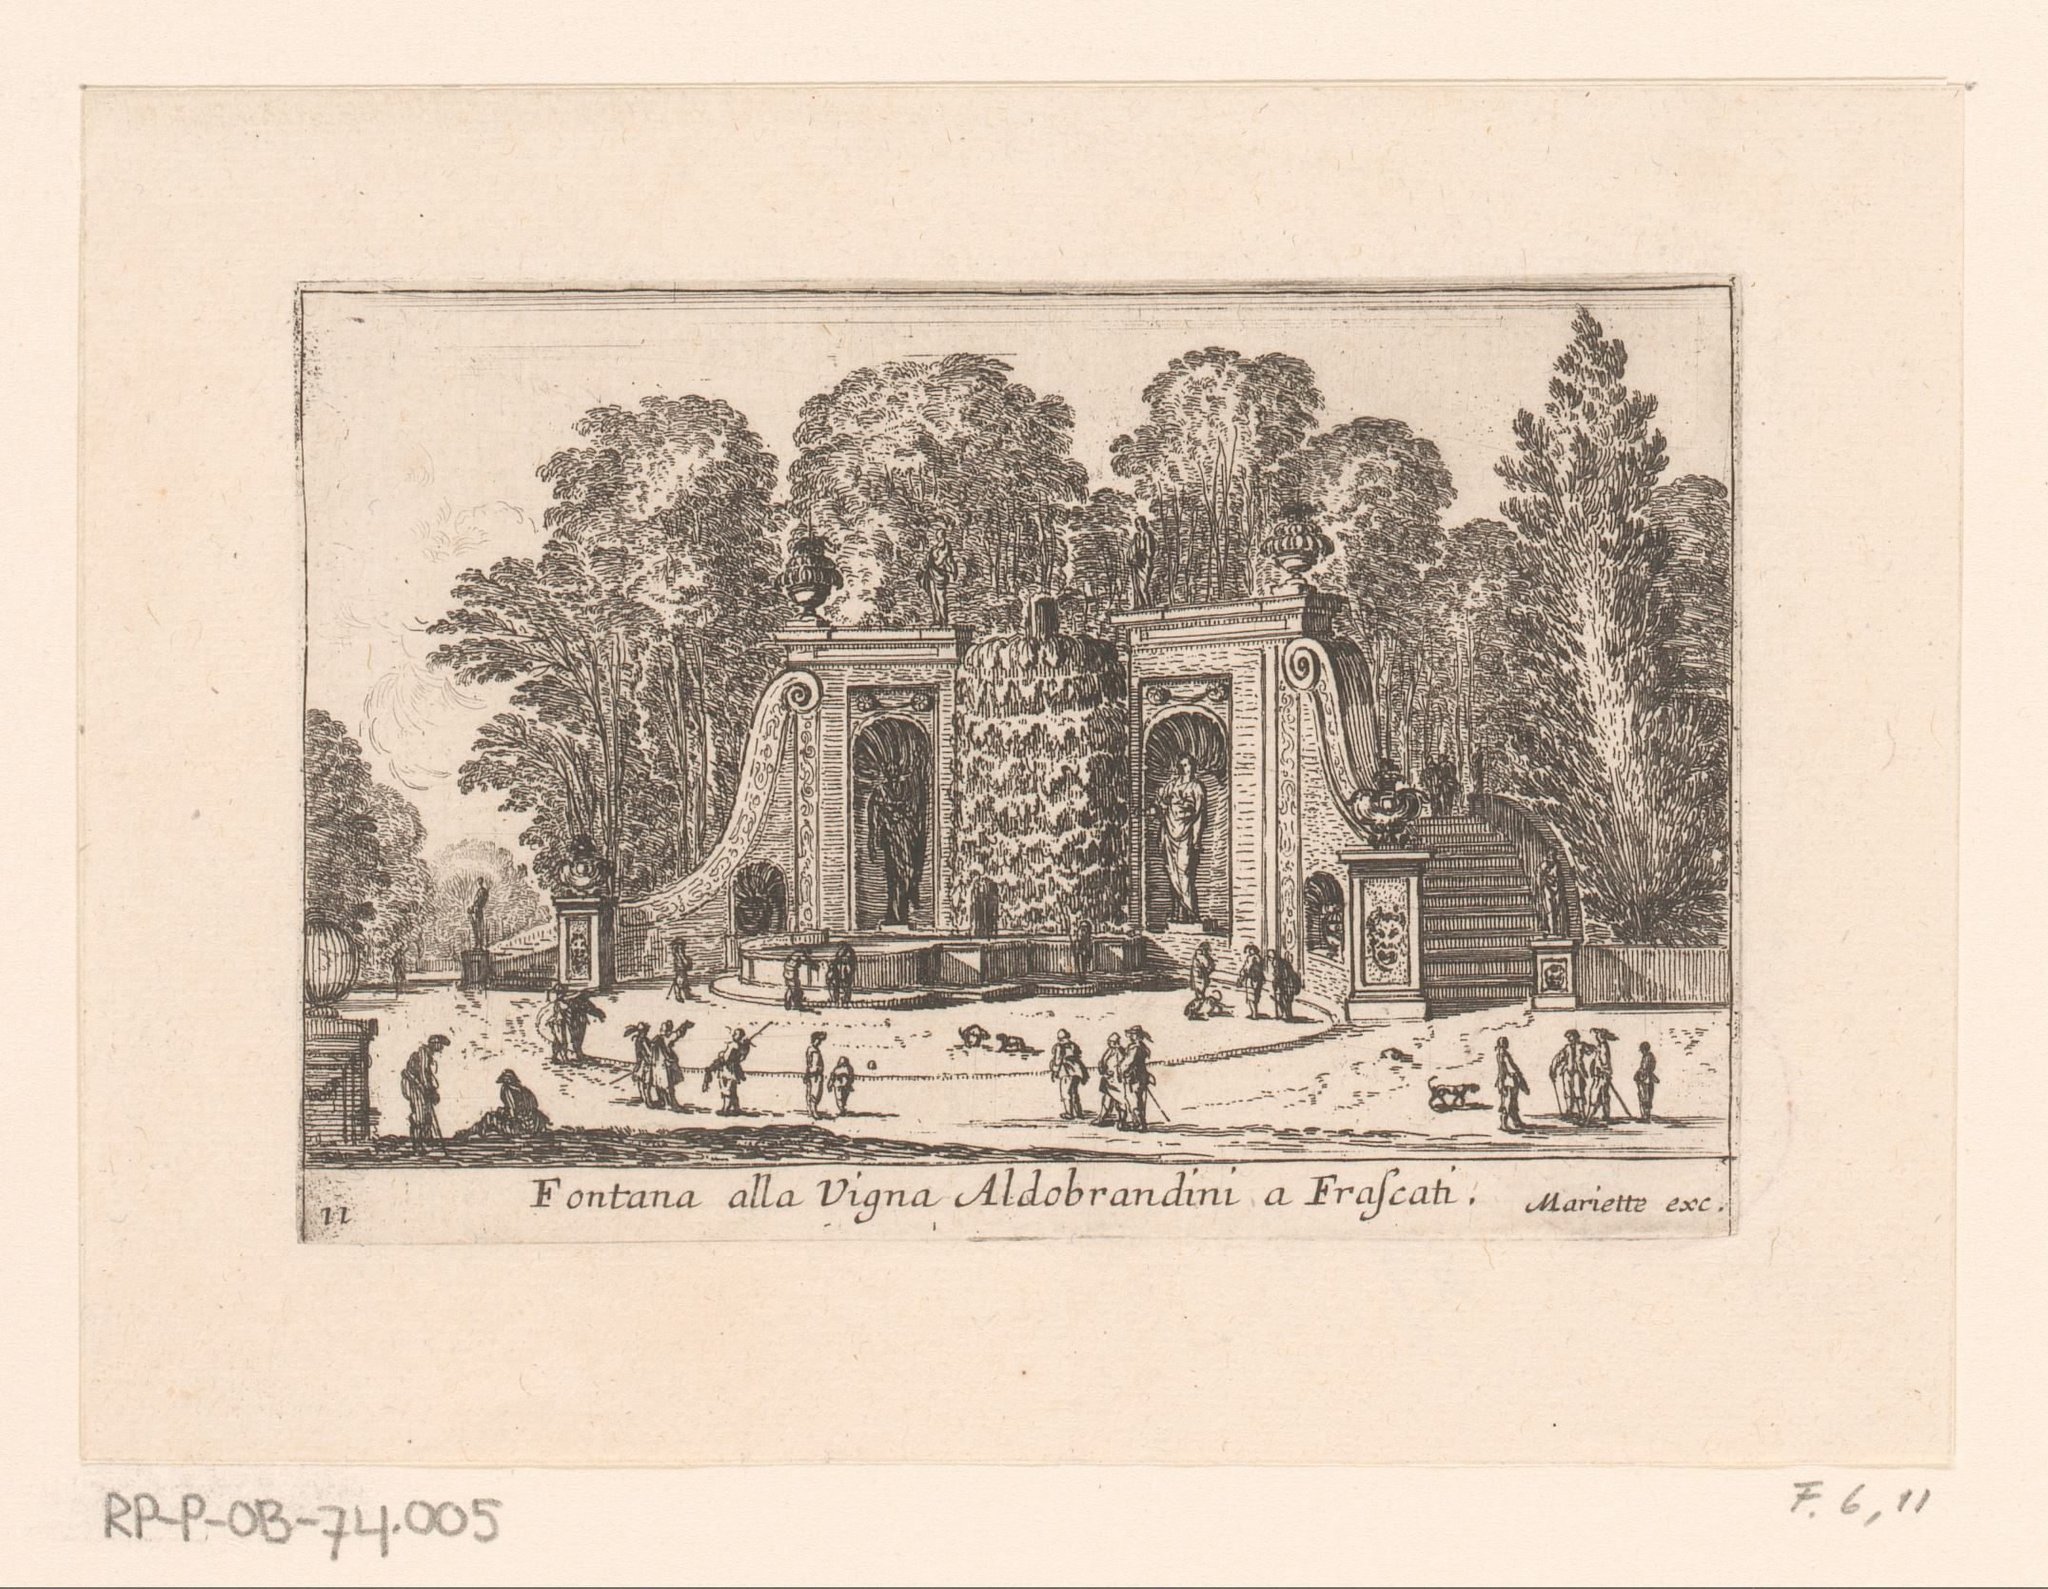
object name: print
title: Fontana alla Vigna Aldobrandini a Frascati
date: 1646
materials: paper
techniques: etching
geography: paris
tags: garden fountain, french or architectonic garden; formal garden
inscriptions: collector's mark: Lugt 240